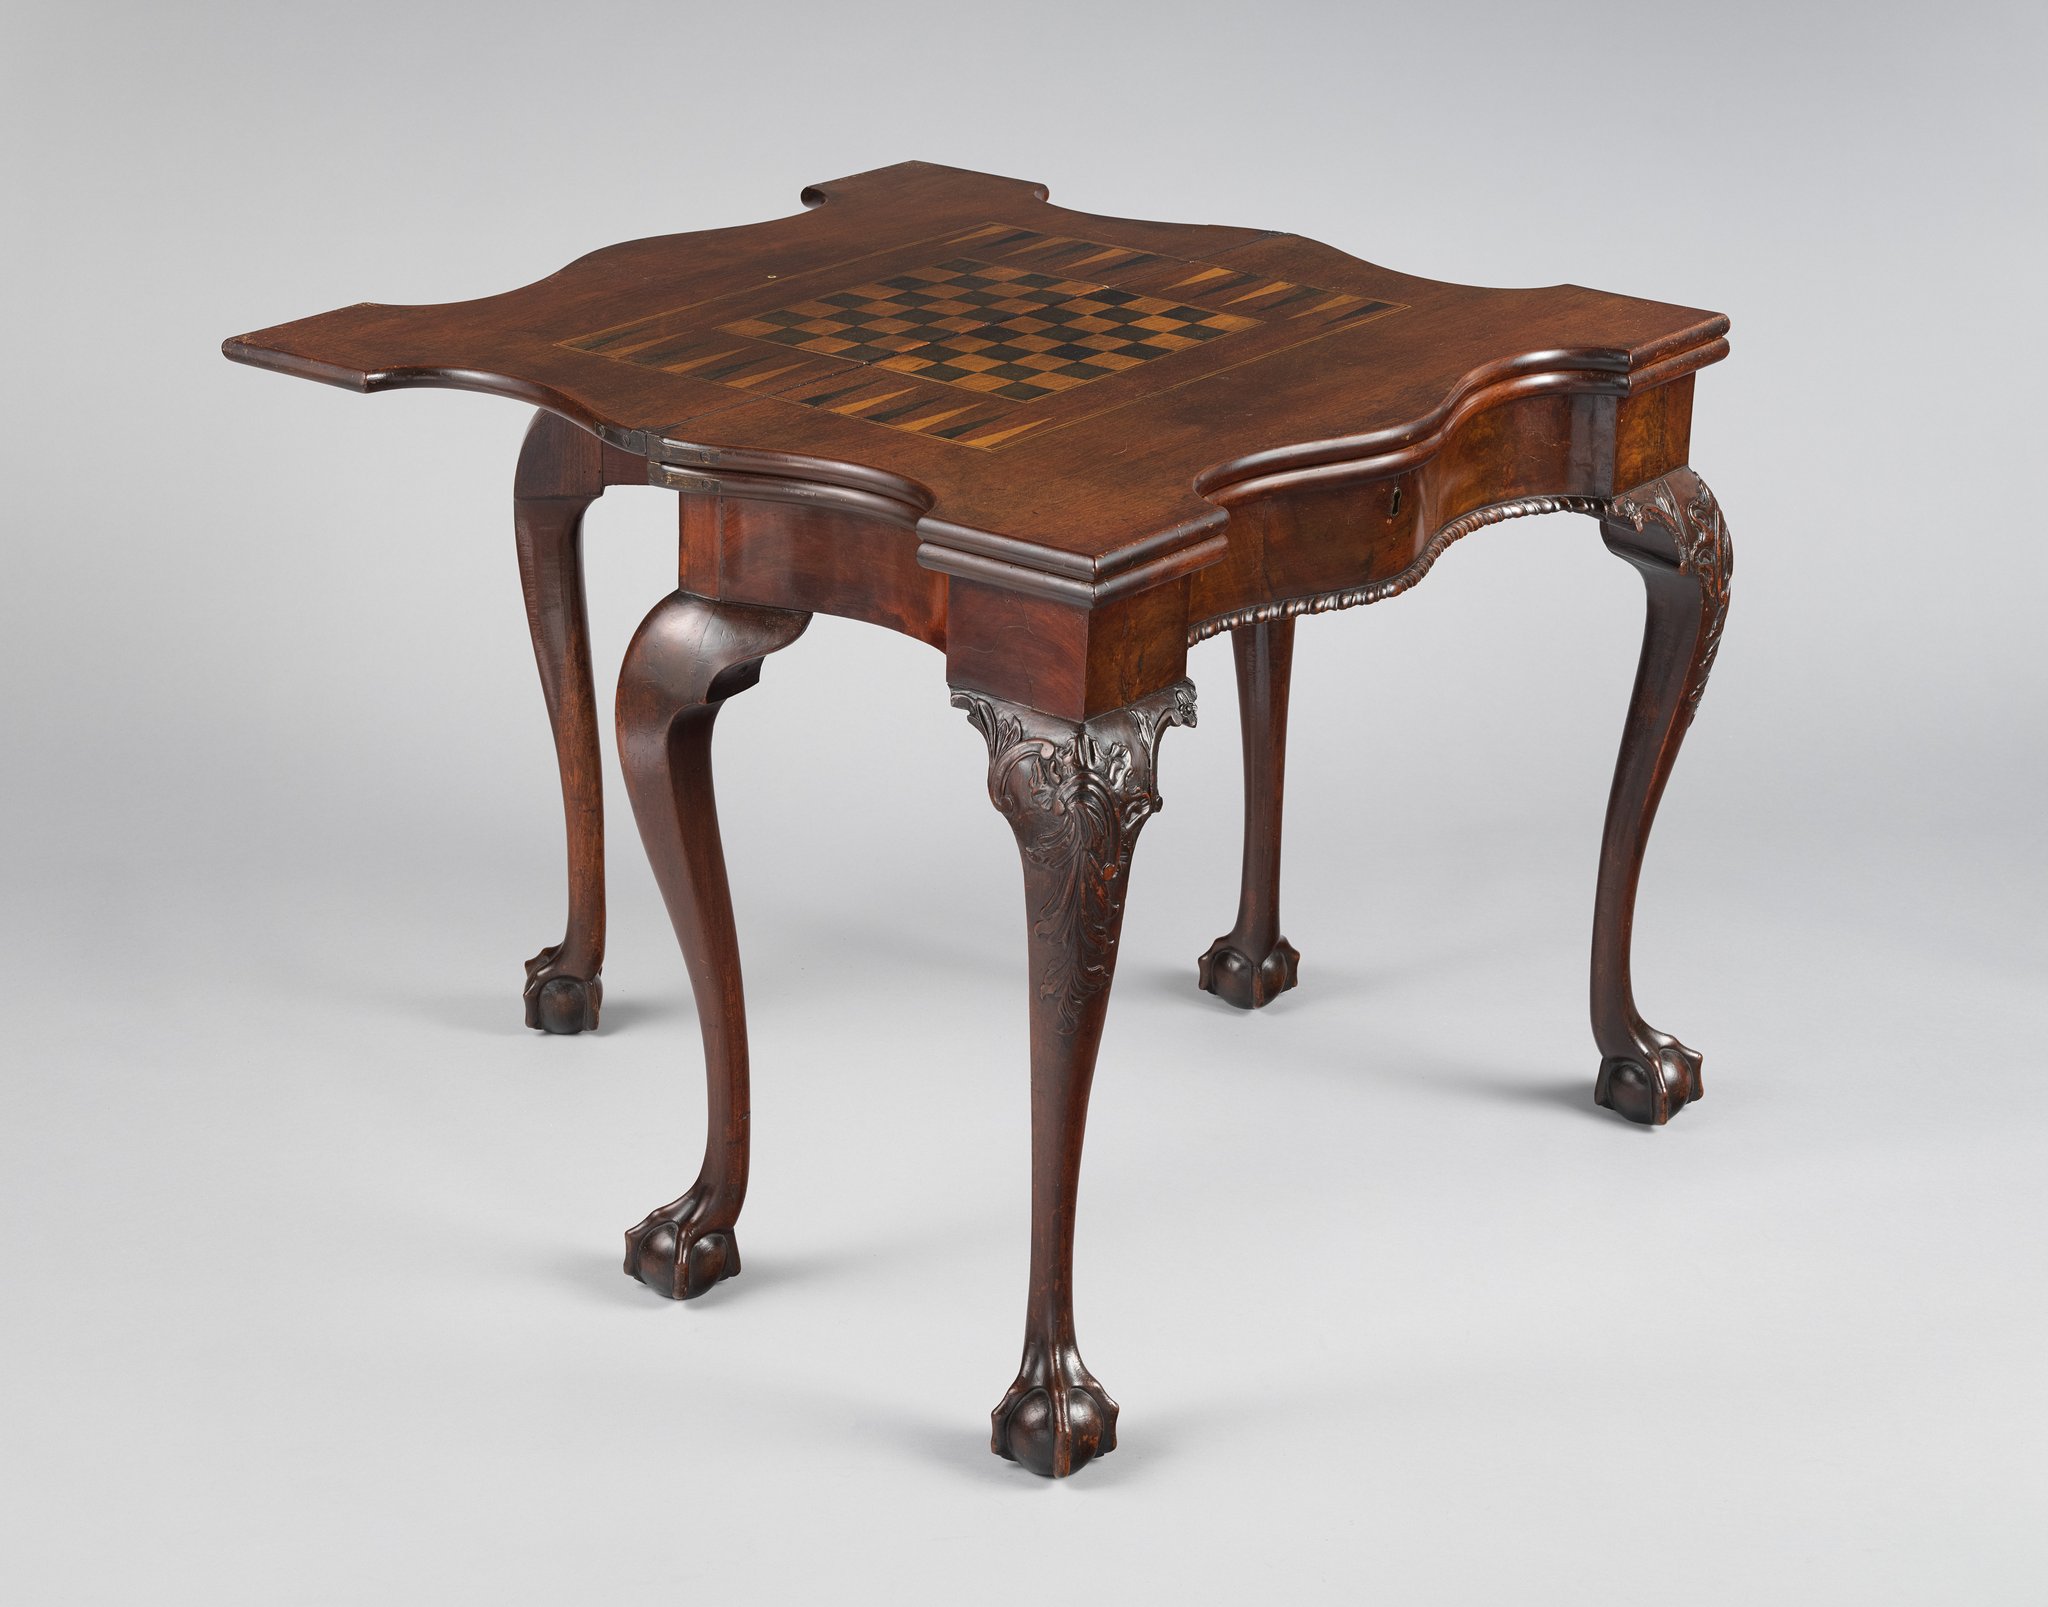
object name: card and backgammon table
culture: american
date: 1760-1790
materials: wood, brass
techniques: inlay, veneering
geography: united states